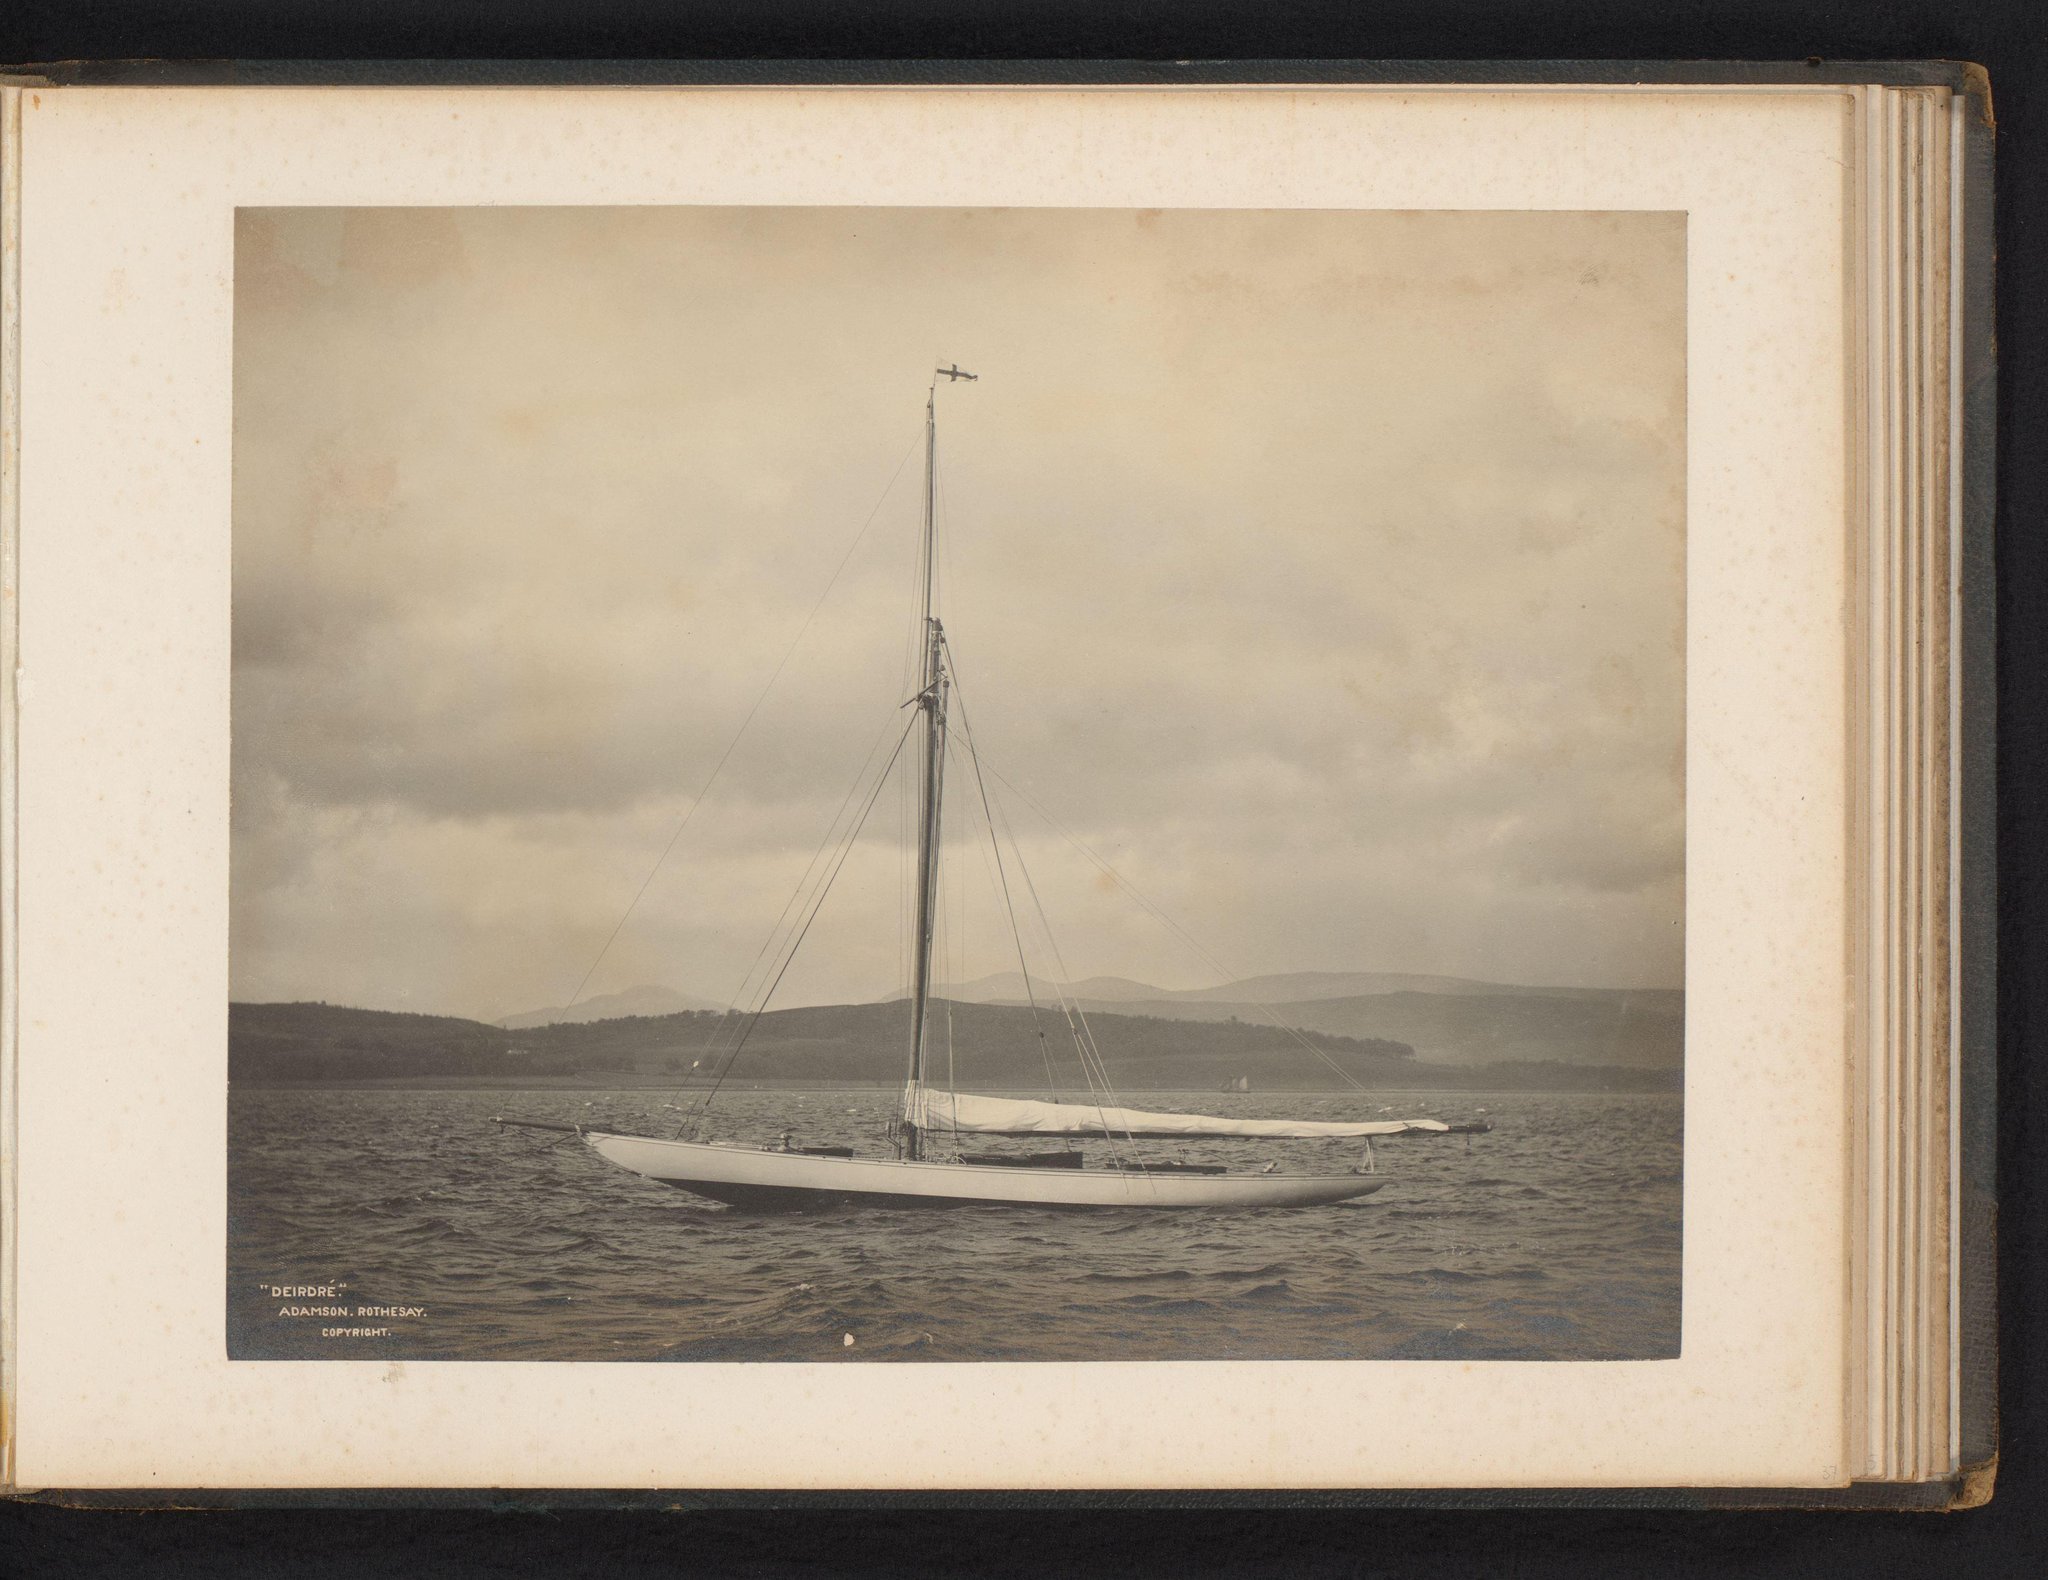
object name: album leaf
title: Zeilschip Deirdré te water met op de achtergrond een heuvelachtig landschap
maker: james adamson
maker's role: fotograaf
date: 1880-1900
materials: photographic support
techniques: gelatin silver print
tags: sailing-ship, sailing-boat, landscapes with waters, waterscapes, seascapes (in the temperate zone), (high) hill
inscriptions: inscription: ‘"Deridré"/ Adamson. Rothesay./ Copyright’, check stamp: ‘Adamson, Rothesay.H.B/ Copyright’